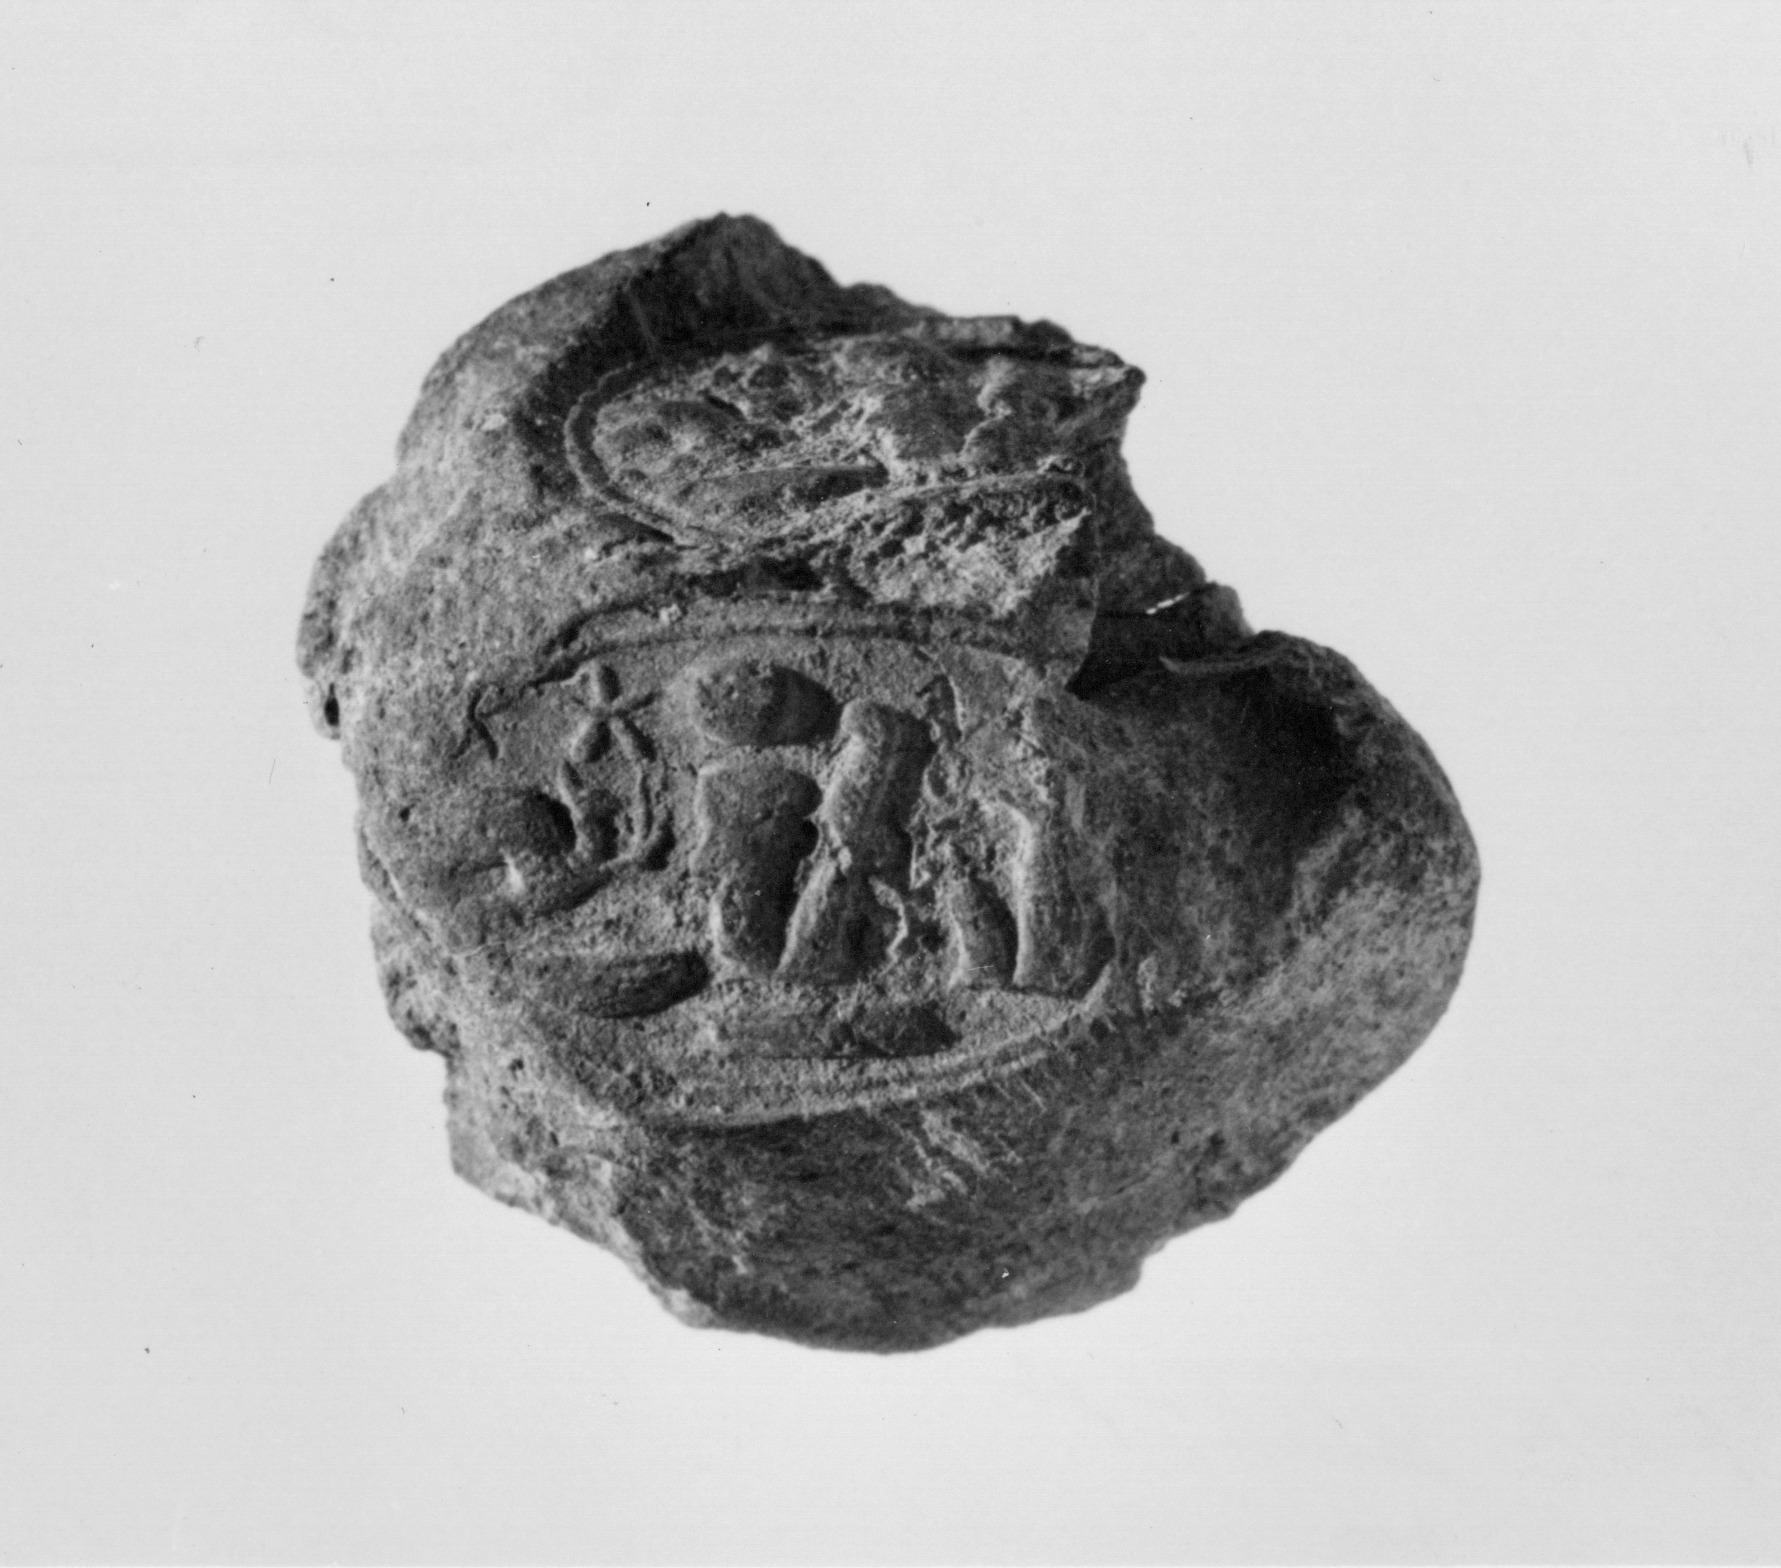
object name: sealing, nebmaatre, amenhotep iii, anubis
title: Document Sealing With the Throne Name of Amenhotep III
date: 1390-1352 BCE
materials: mud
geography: egypt